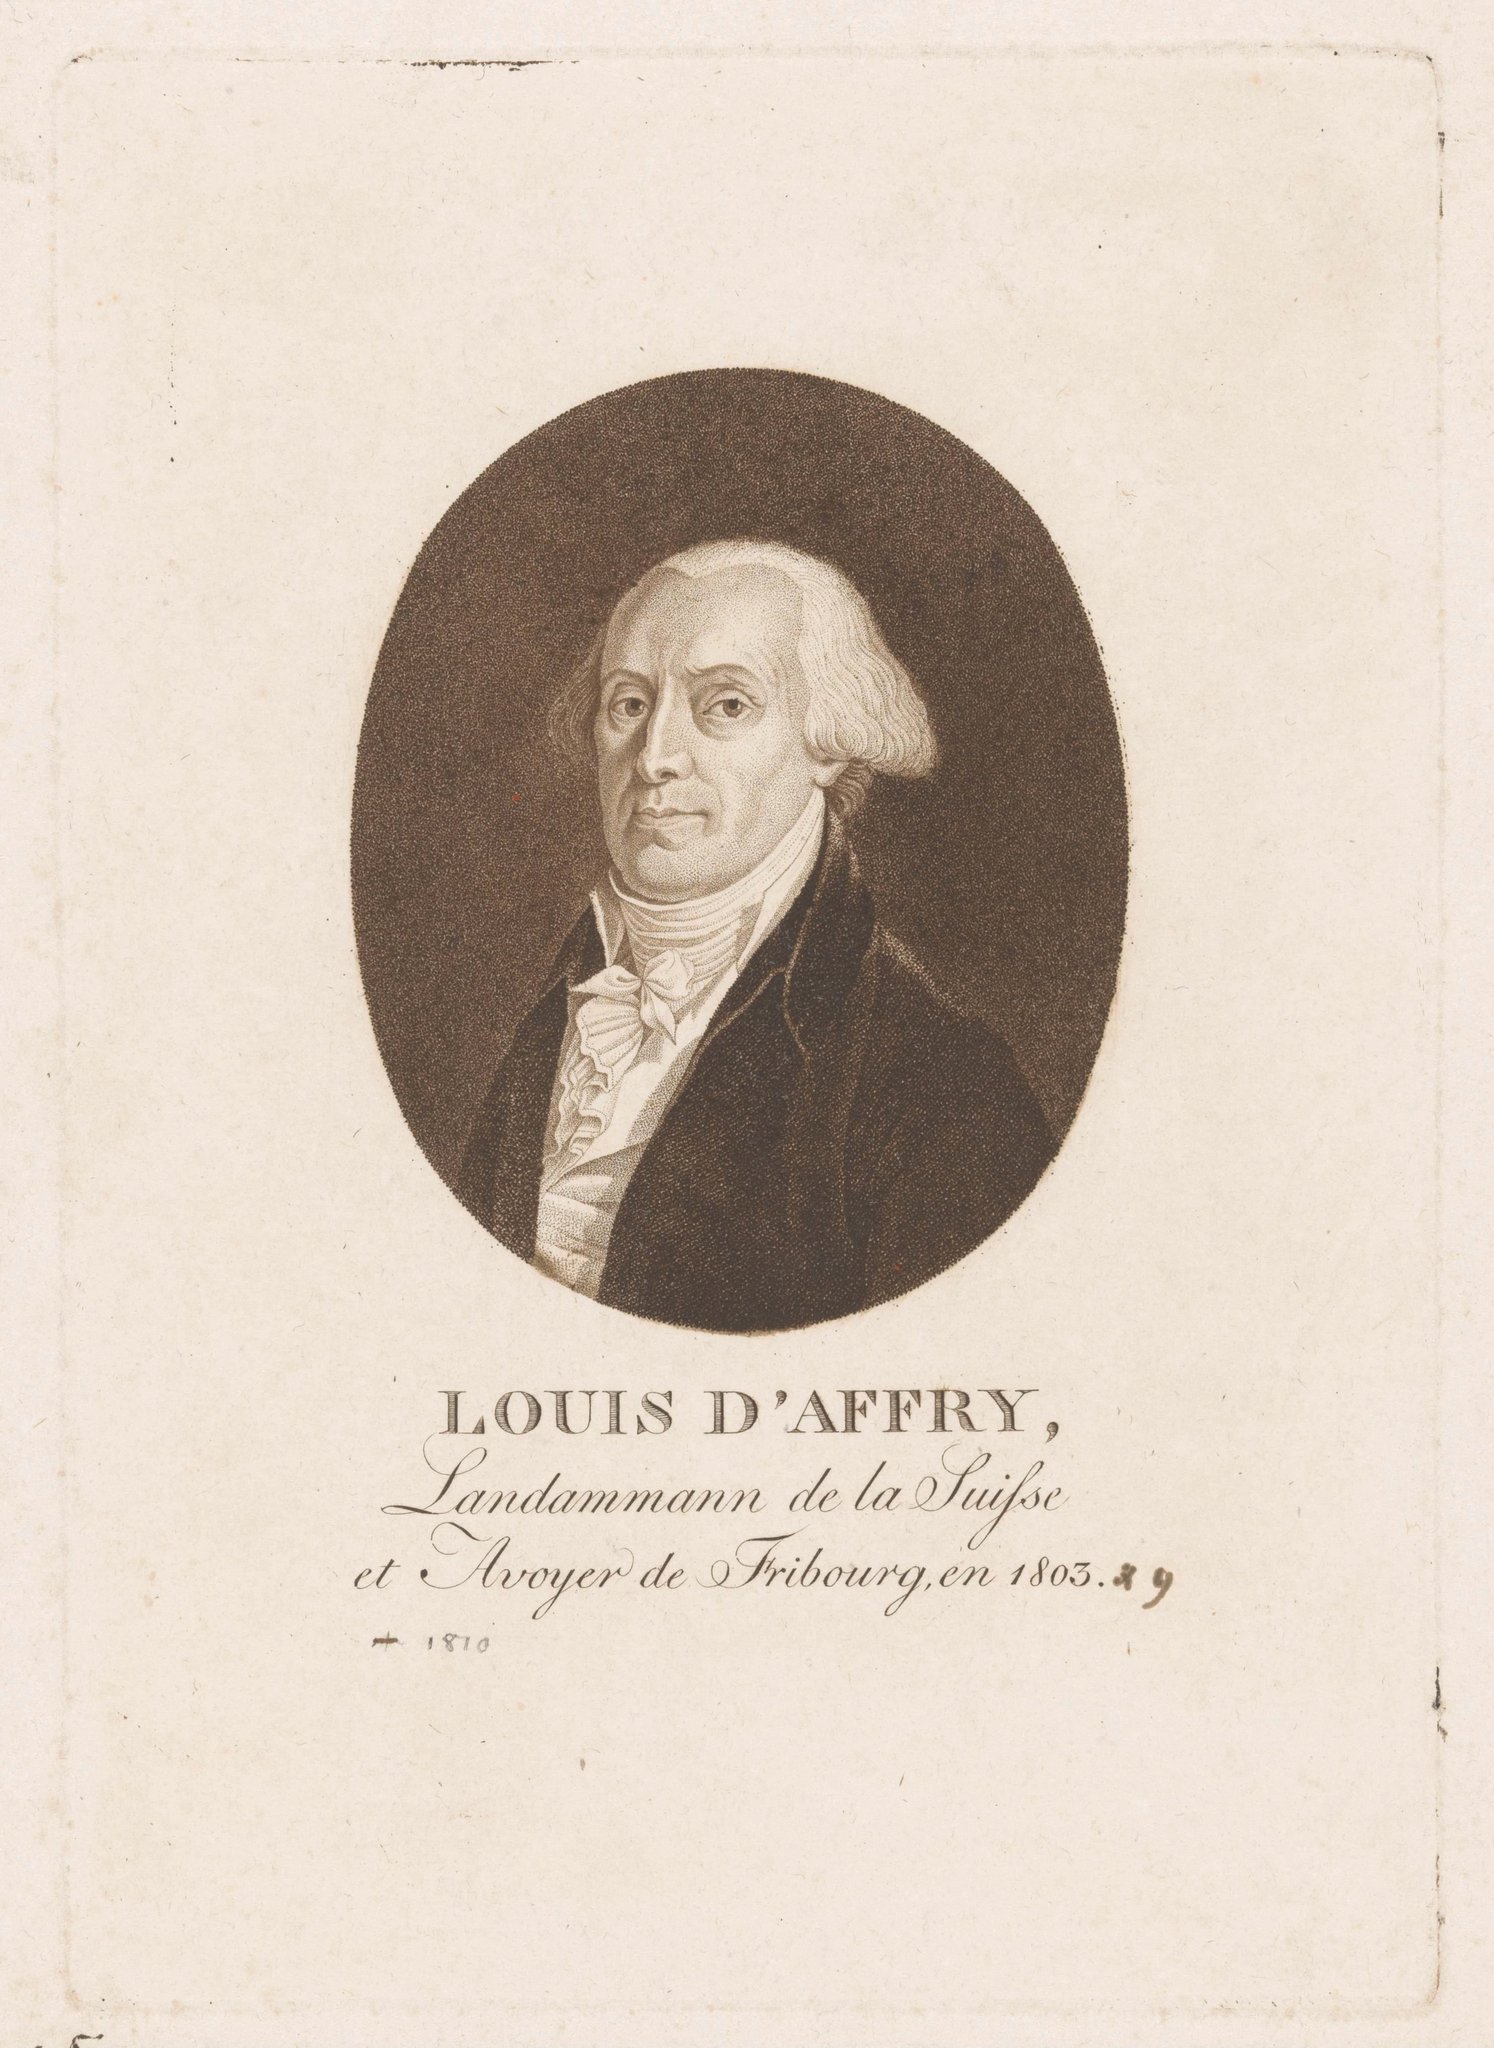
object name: print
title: Portret van Louis d' Affry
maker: Anonymous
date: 1803-1899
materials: paper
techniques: aquatint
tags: politician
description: Portret van Louis d' Affry in een ovale omlijsting. In de ondermarge zijn naam en twee regels Franse tekst.